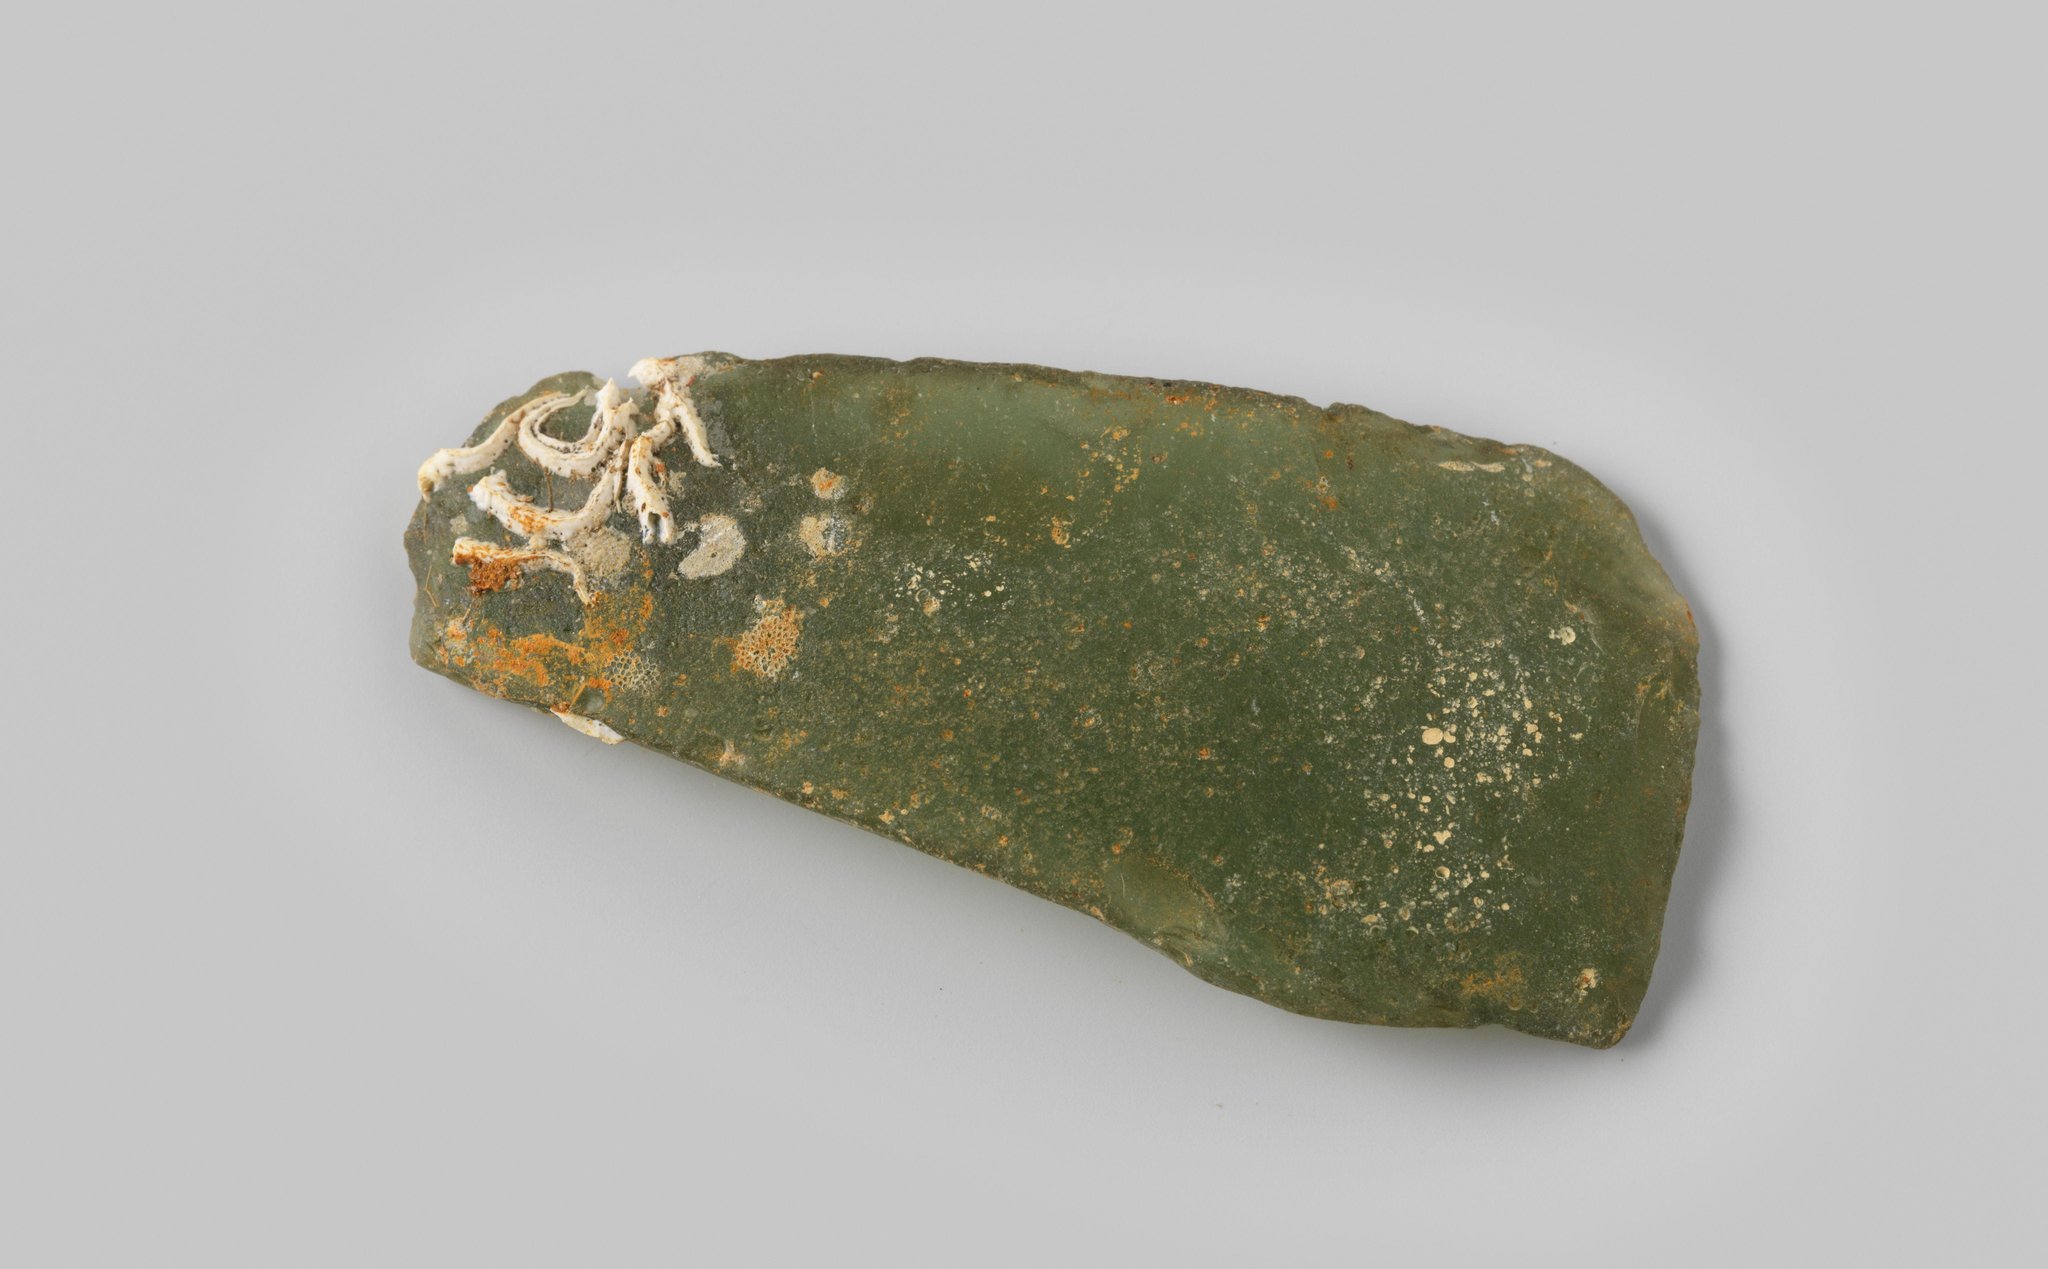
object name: wine bottle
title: Scherf van een wijnfles uit het wrak van de Oost-Indiëvaarder Hollandia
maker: Anonymous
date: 1700-1743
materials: glass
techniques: green glass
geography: netherlands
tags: verenigde oostindische compagnie, hollandia (schip), annet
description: Typologically not identifiable, belly, fragment.